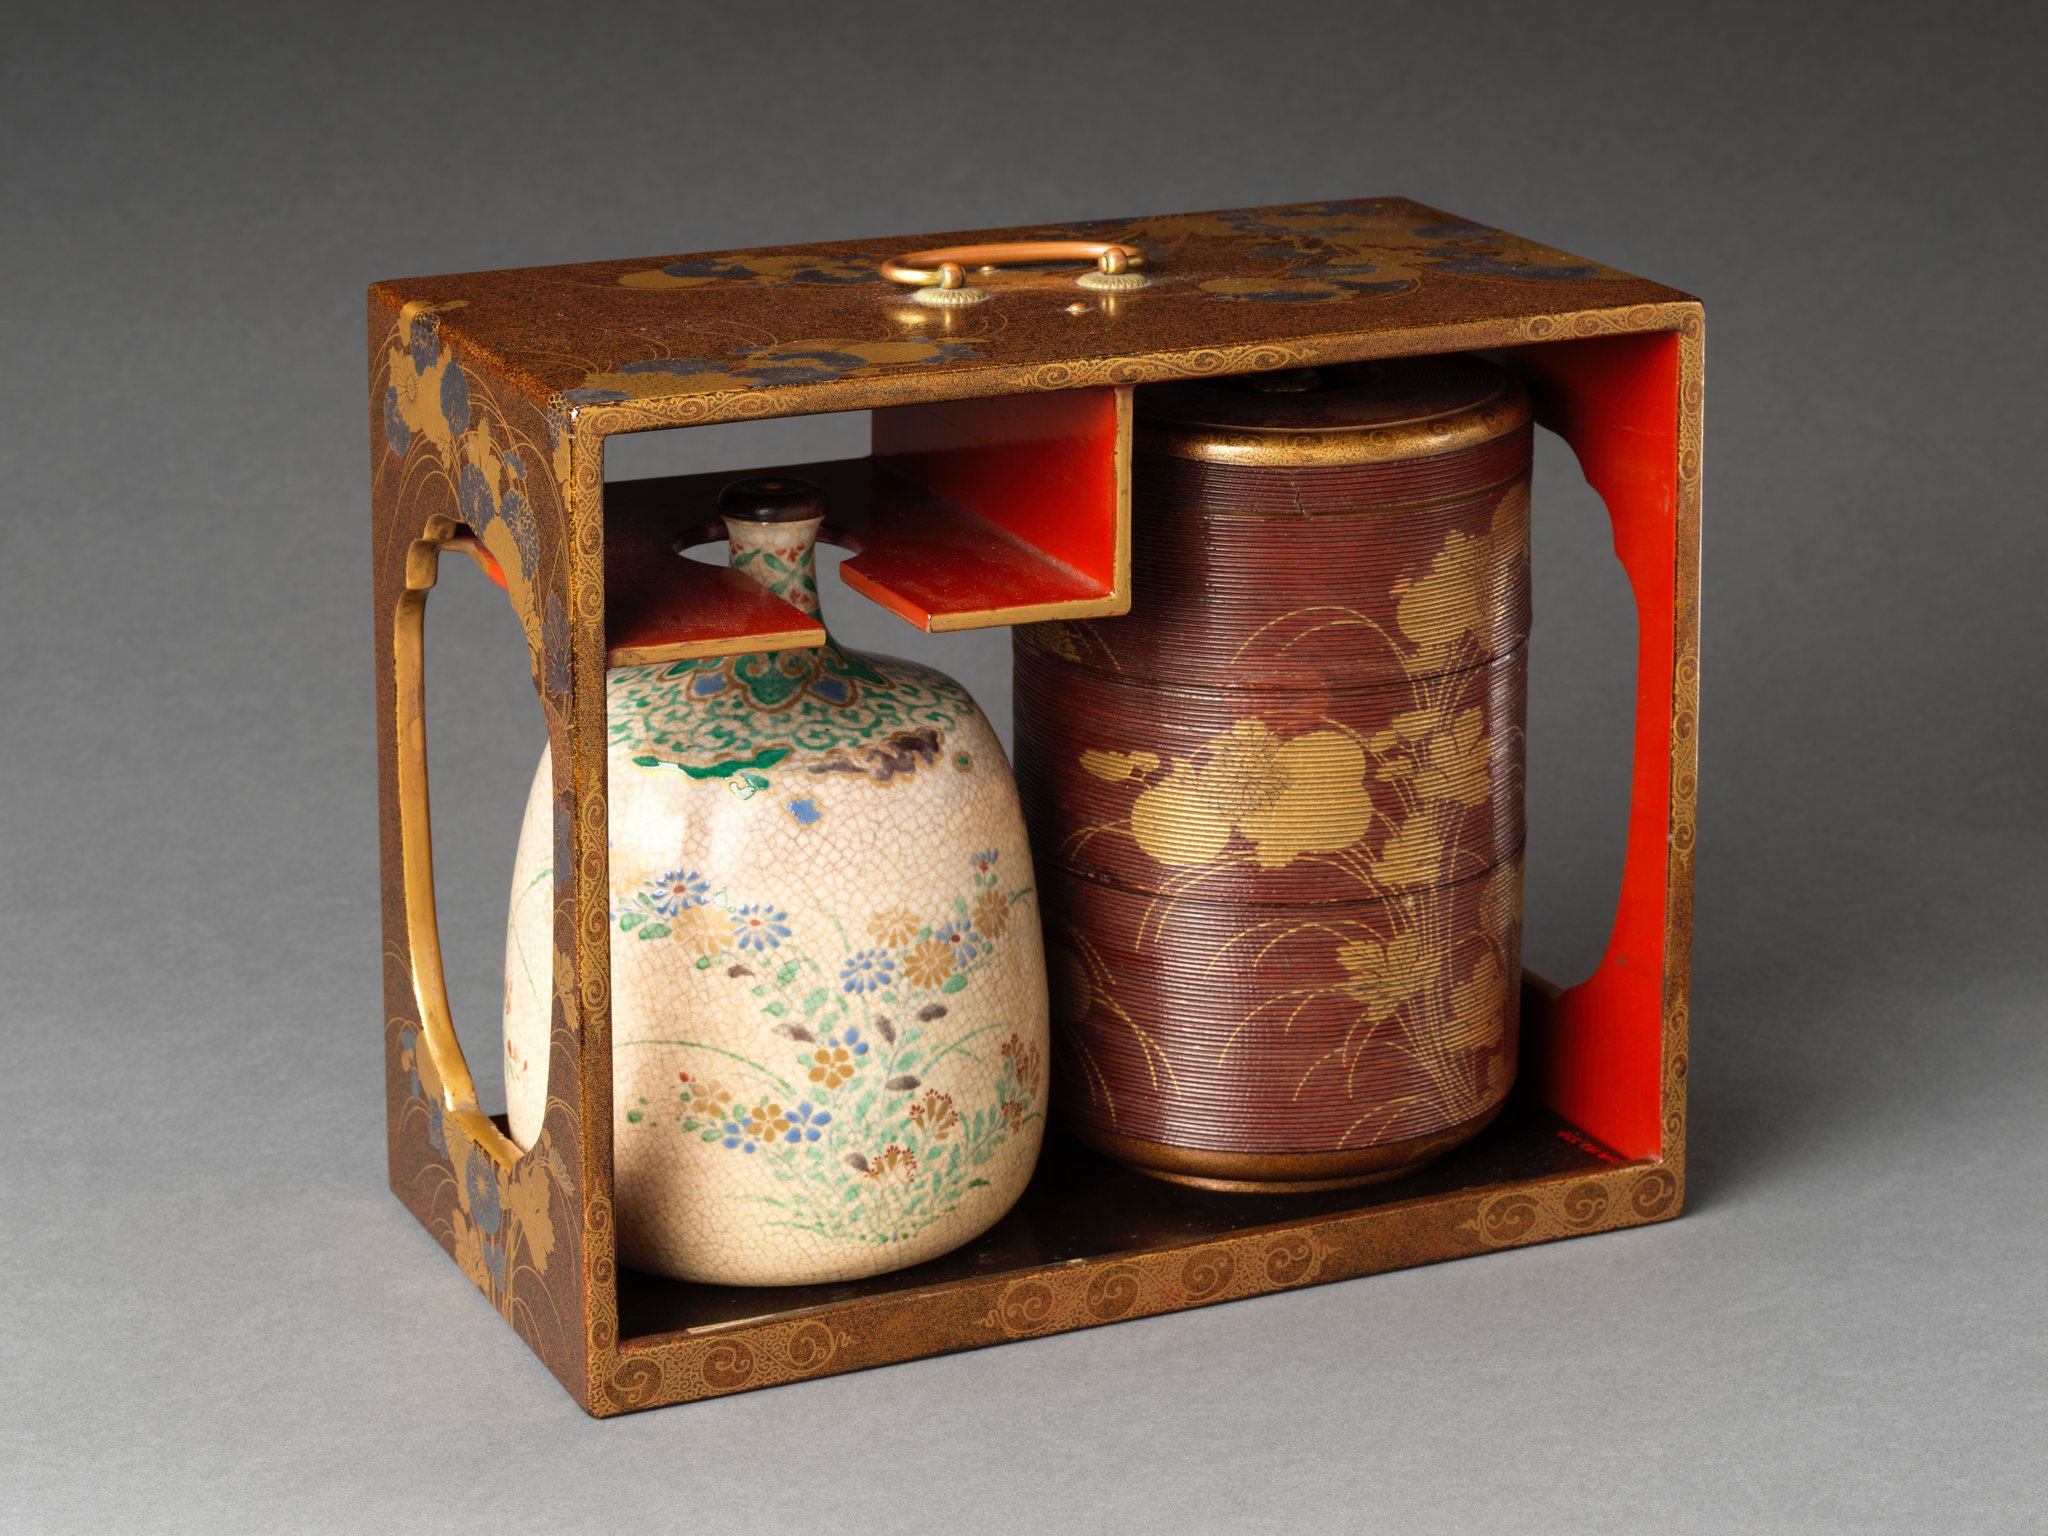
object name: picnic set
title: Picnic set with decoration of chrysanthemum and autumn grasses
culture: japanese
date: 1701-1800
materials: gold, lacquer, silver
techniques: glazing, maki